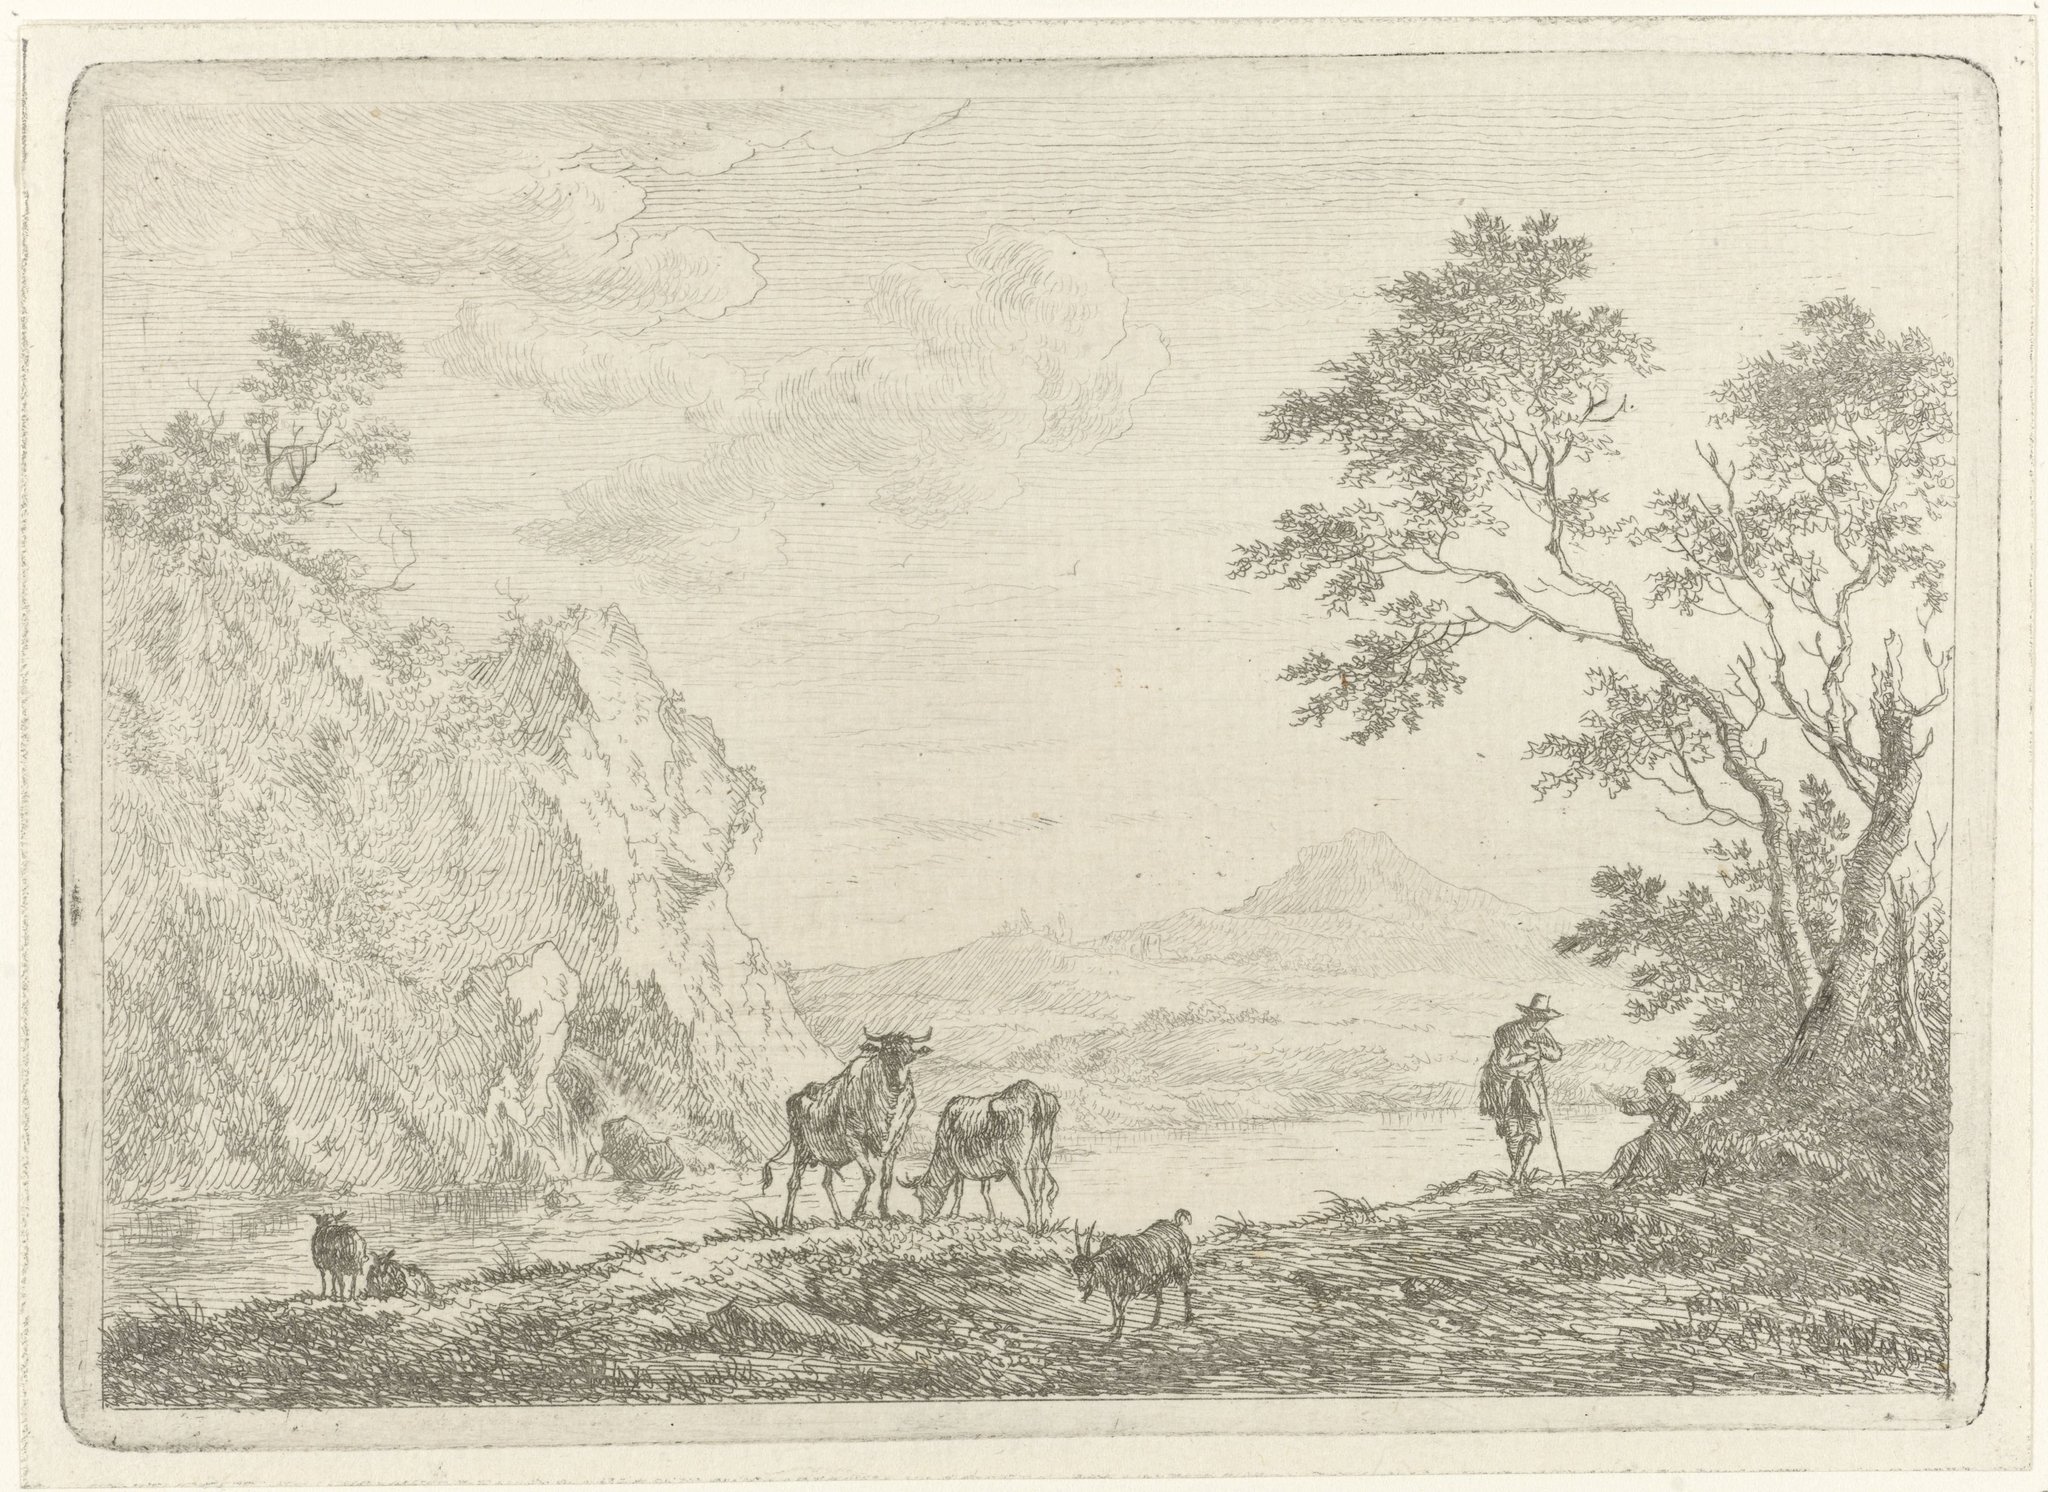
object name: print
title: Bergachtig landschap met herder en vee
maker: johannes janson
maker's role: draughtsman, painter, print maker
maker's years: 1729-1784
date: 1761-1784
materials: paper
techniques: etching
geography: leiden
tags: herding, herdsman, herdswoman, shepherd, shepherdess, cowherd, etc., landscapes (+ landscape with figures, staffage)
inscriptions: collector's mark: Lugt 240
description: Bergachtig landschap met een herder in gesprek met een zittende vrouw. Twee schapen, twee koeien en een bok staan bij een rivier. Prent uit een serie met landschappen.